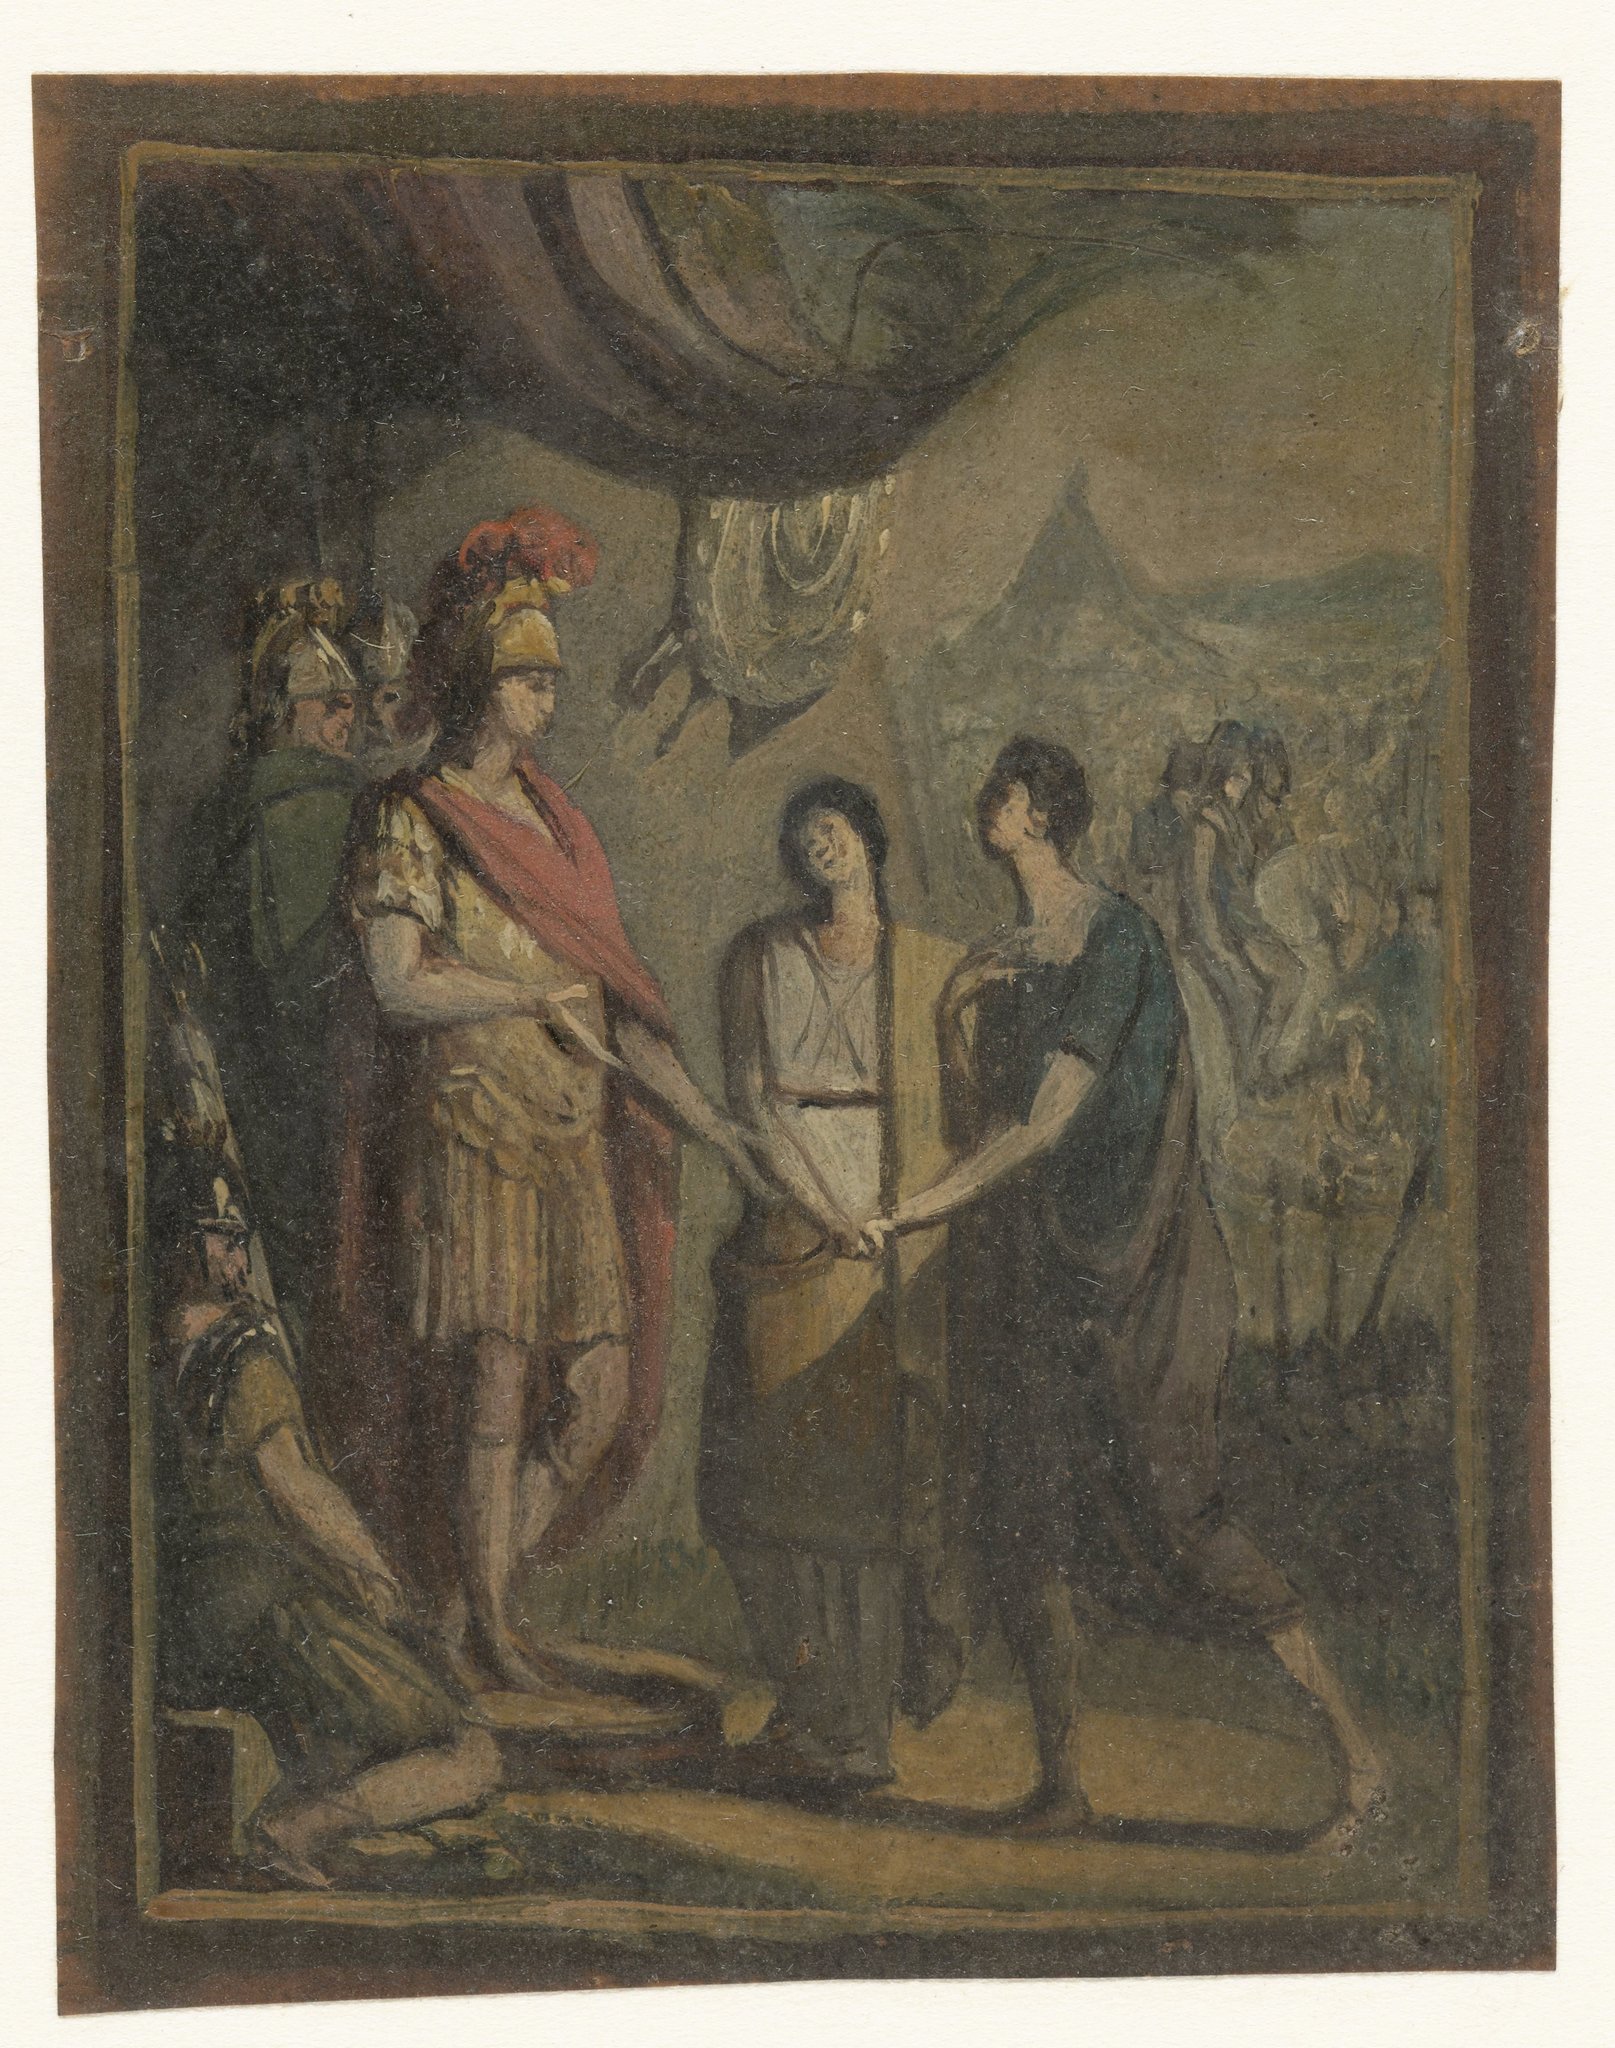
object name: drawing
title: Twee jongelingen voorgesteld aan een veldheer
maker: Anonymous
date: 1700-1800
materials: oil, paper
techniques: brush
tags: officer